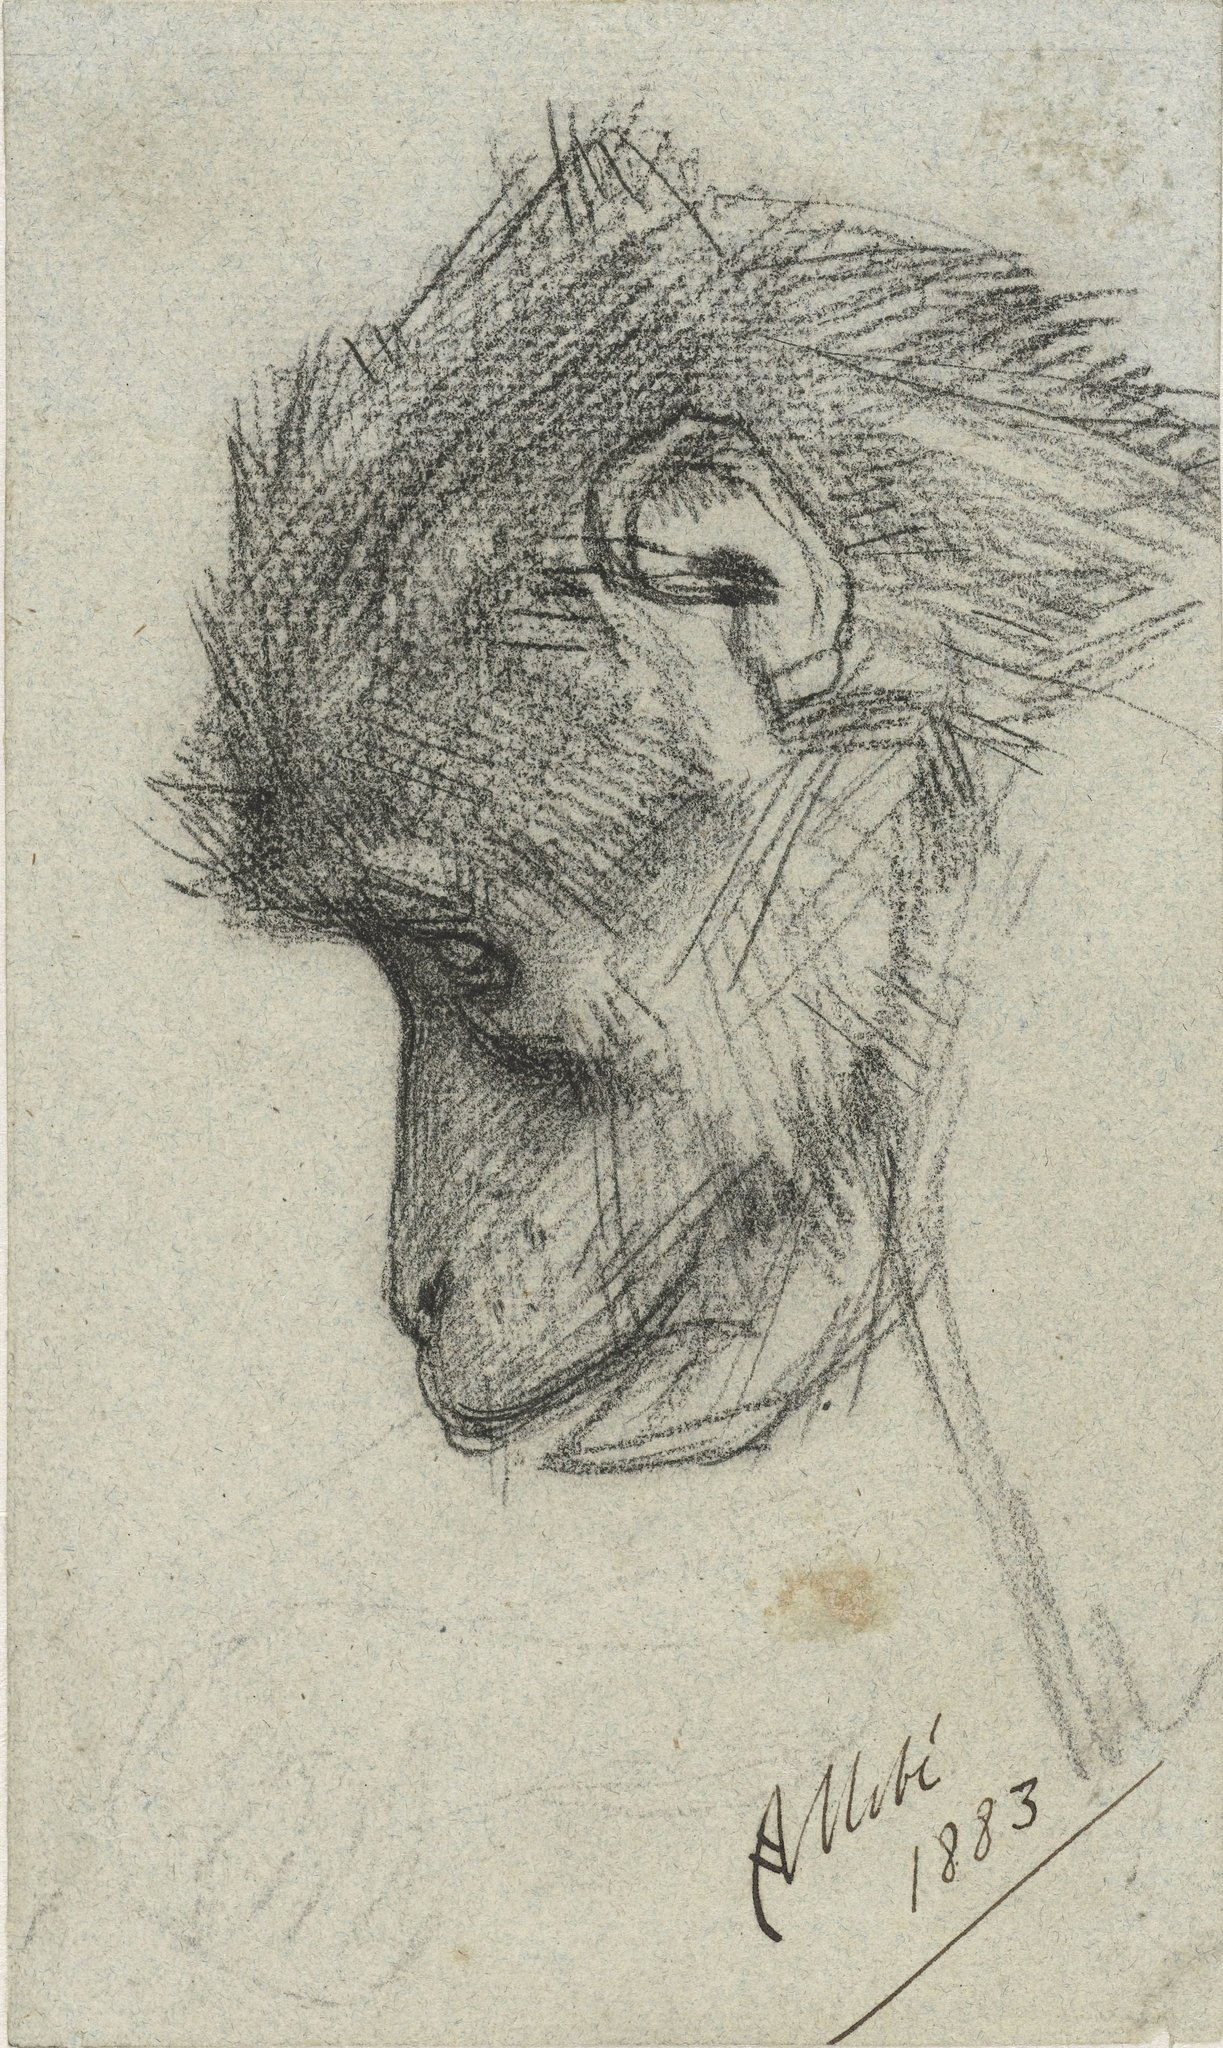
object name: drawing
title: Kop van een aap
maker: august allebé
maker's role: draughtsman, print maker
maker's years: 1838-1927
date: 1883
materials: chalk, paper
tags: monkeys, apes